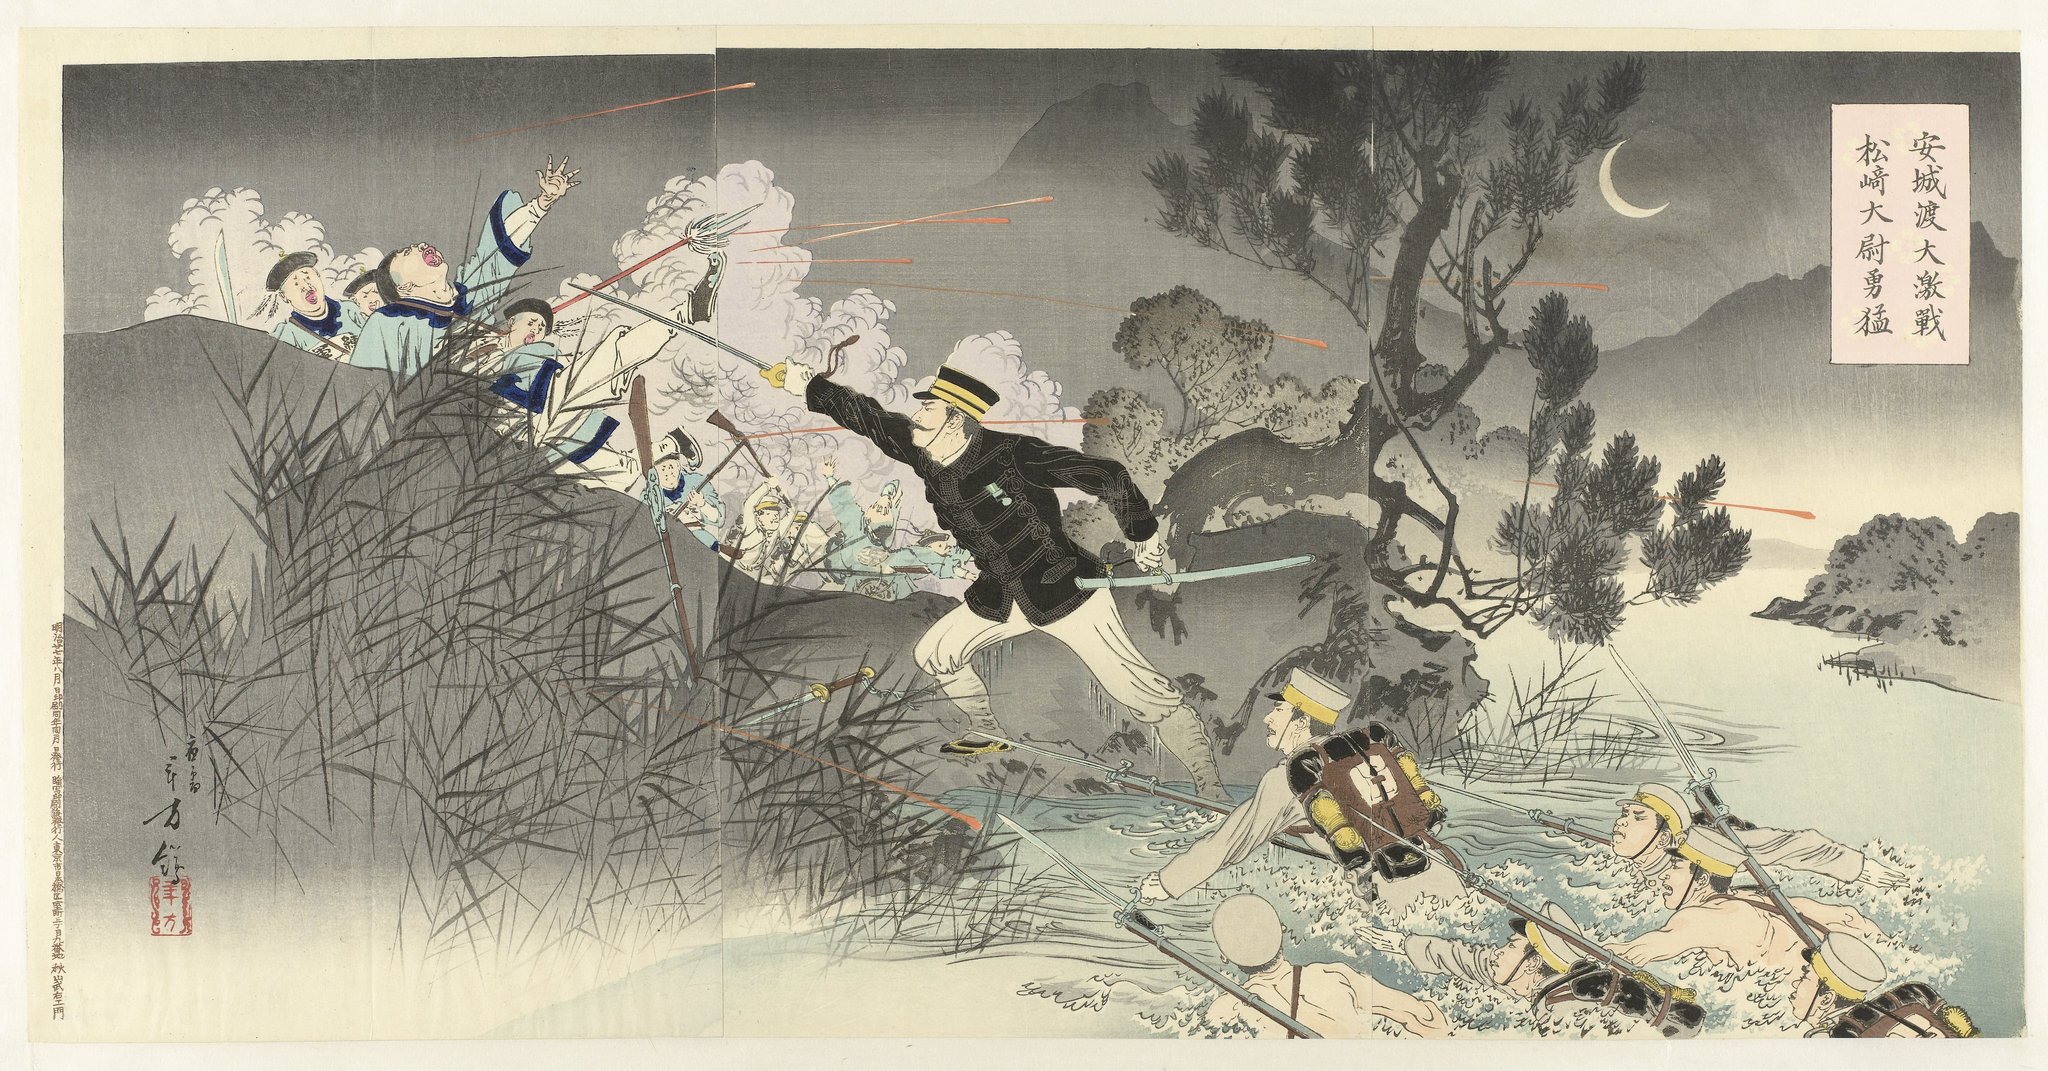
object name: print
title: De heftige strijd bij de Ansung rivier, de heldhaftigheid van Kapitein Matsuzaki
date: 1894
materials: paper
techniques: woodcut, polish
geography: japan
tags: river, commander-in-chief, general, marshal, (military) attack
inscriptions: date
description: Kapitein Matsuzaki Naomi leidt zijn mannen over de Ansung rivier op 28 juli 1894. Hij werd geraakt maar spoorde zijn leger aan om de vijand aan te vallen totdat hij gedood werd door een tweede kogel. De slag bij Asan vond plaats tijdens de Eerste Chinees-Japanse Oorlog (1894-1895).